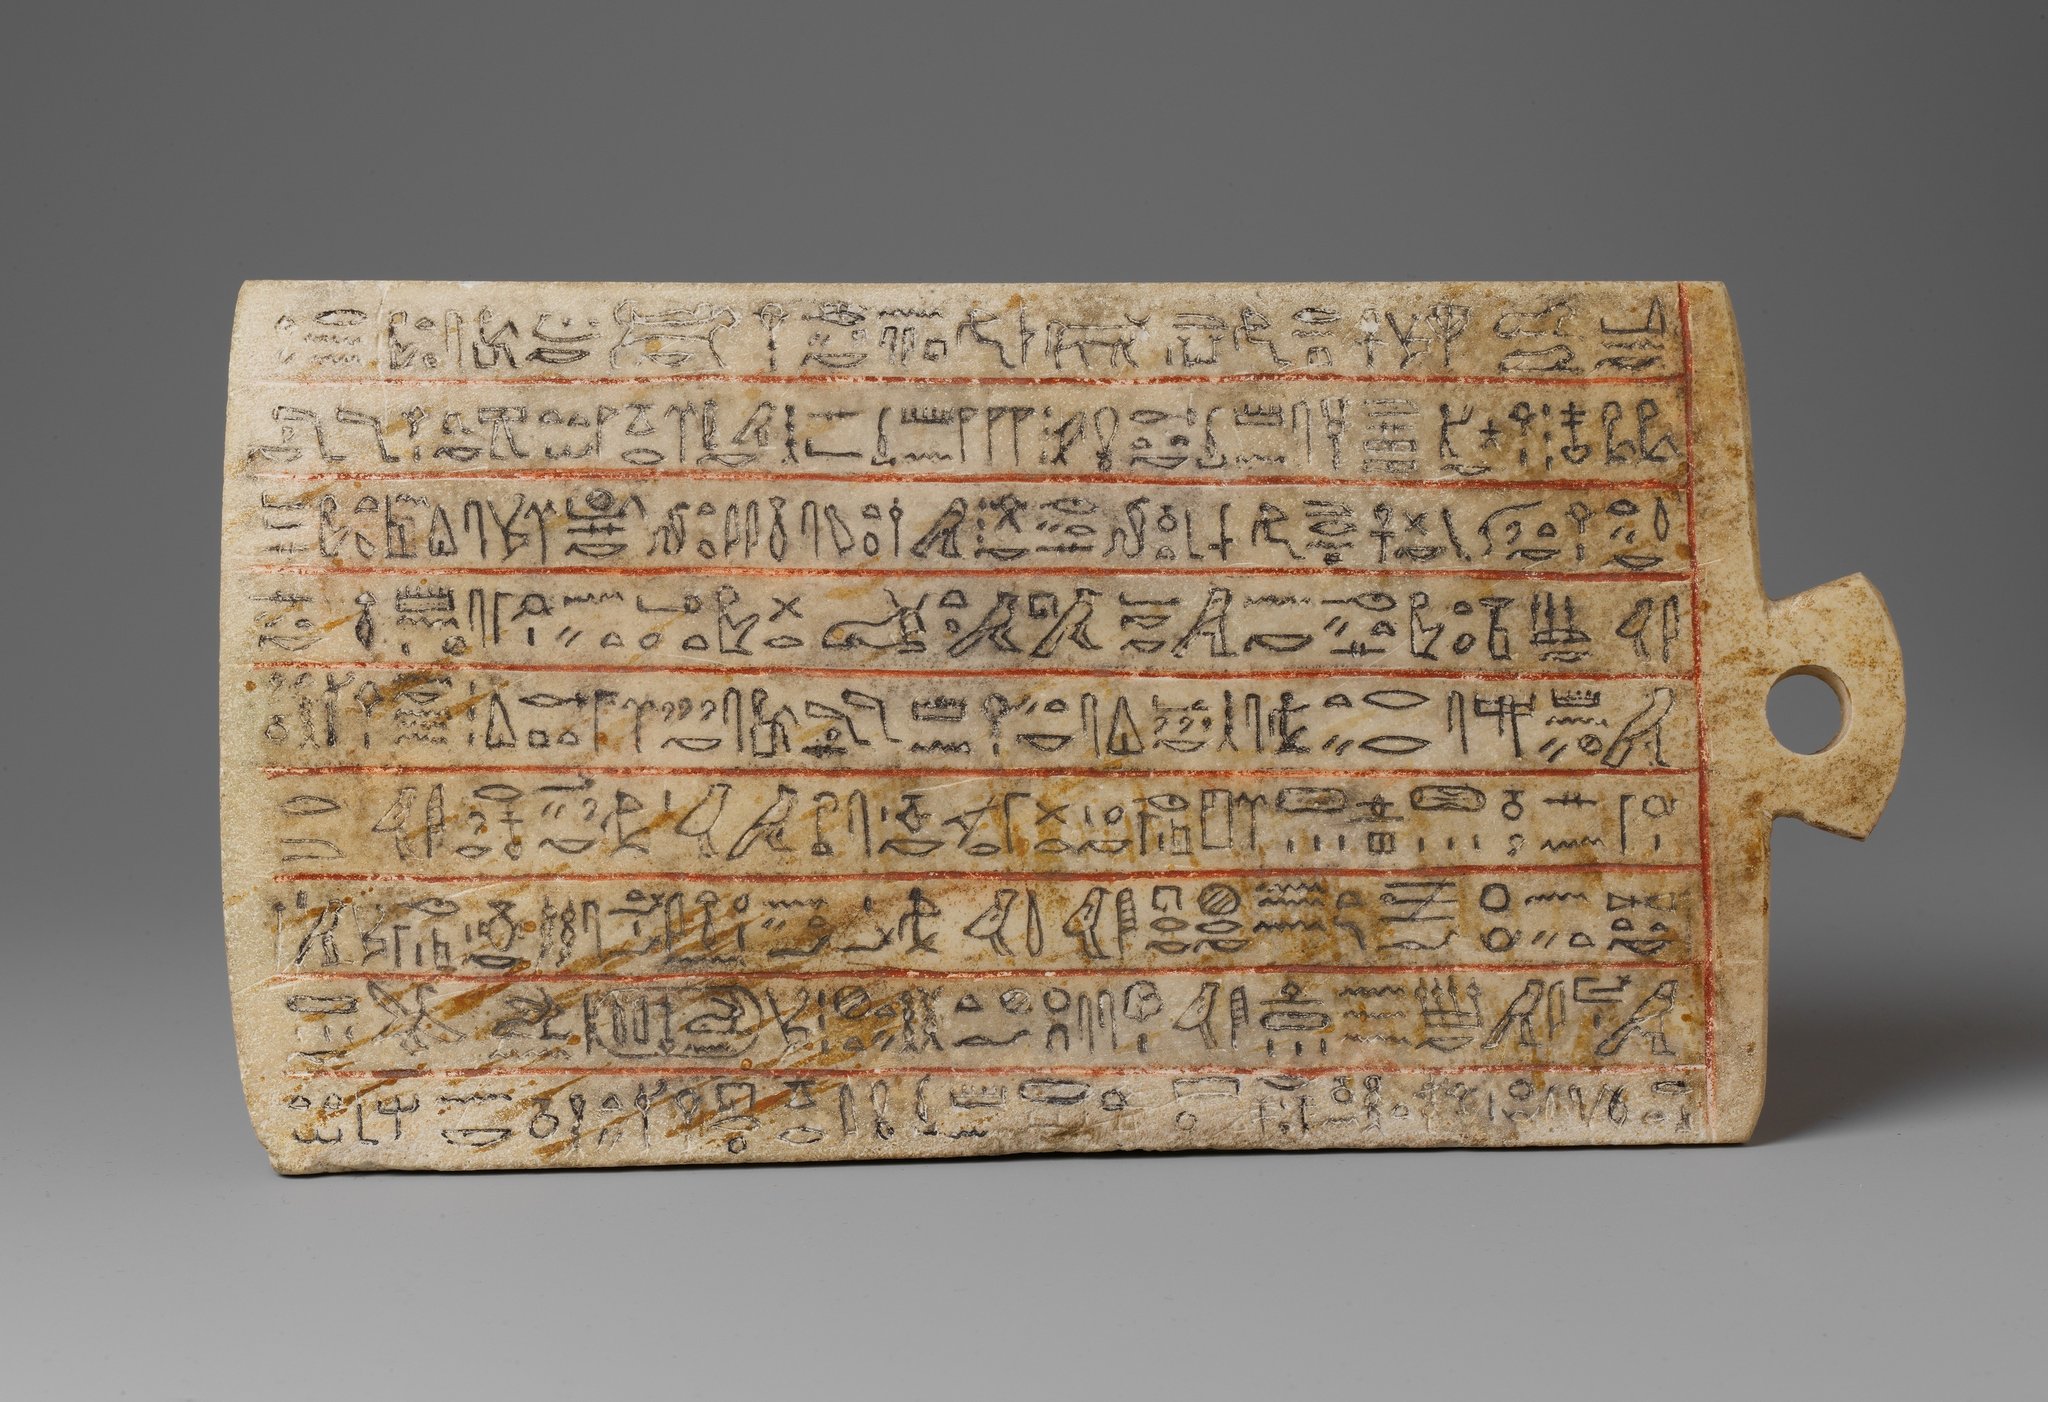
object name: tablet, funerary, horpaa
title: Funerary Tablet of Horpaa, priest at Hermopolis and son of Djehutyhor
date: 332-330 BCE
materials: alabaster, paint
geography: middle egypt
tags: hieroglyphs